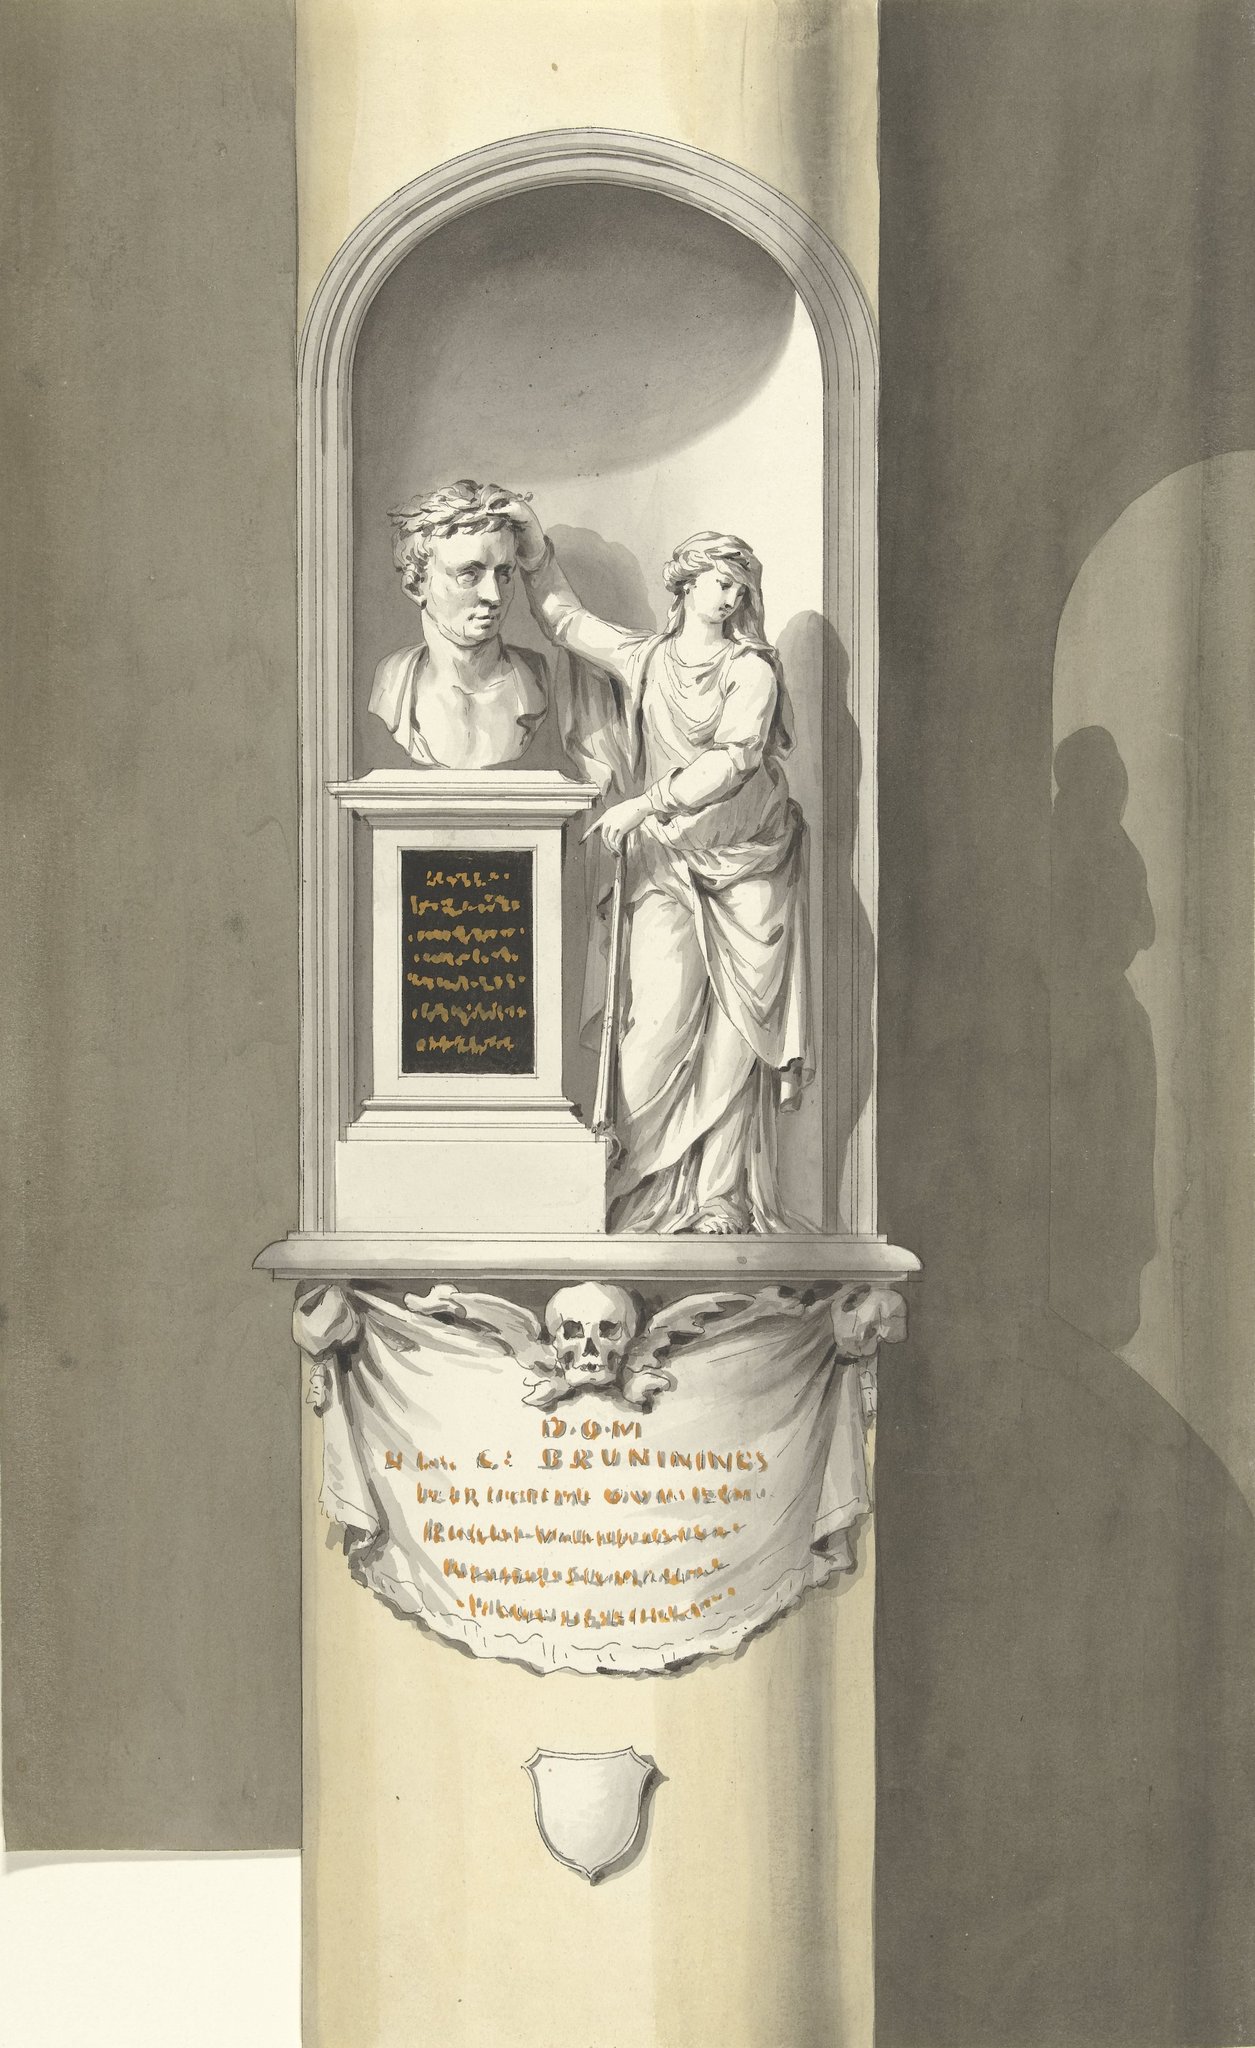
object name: drawing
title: Ontwerp voor een monument voor C. Brunings: een borstbeeld in een nis met Fama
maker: bartholomeus ziesenis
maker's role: draughtsman, sculptor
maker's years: 1768-1820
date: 1806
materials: paper, watercolor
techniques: brush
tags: christiaan l. brunings (i), historical persons, piece of sculpture, reproduction of a piece of sculpture, other memorial structures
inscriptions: inscription: ‘No.4 / Ziesenis. / architect / 12 junij 1806 / inv: et del. / [potlood:] f 16000.-’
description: De heer M. Zisenis (E: dr.zisenis@zifec.de) gaf aan dat het hier om de vervaardiger Bartholomeus Ziesenis gaat. Na goedkeuring van Robert-Jan te Rijdt record aangepast. (2012-02-13)